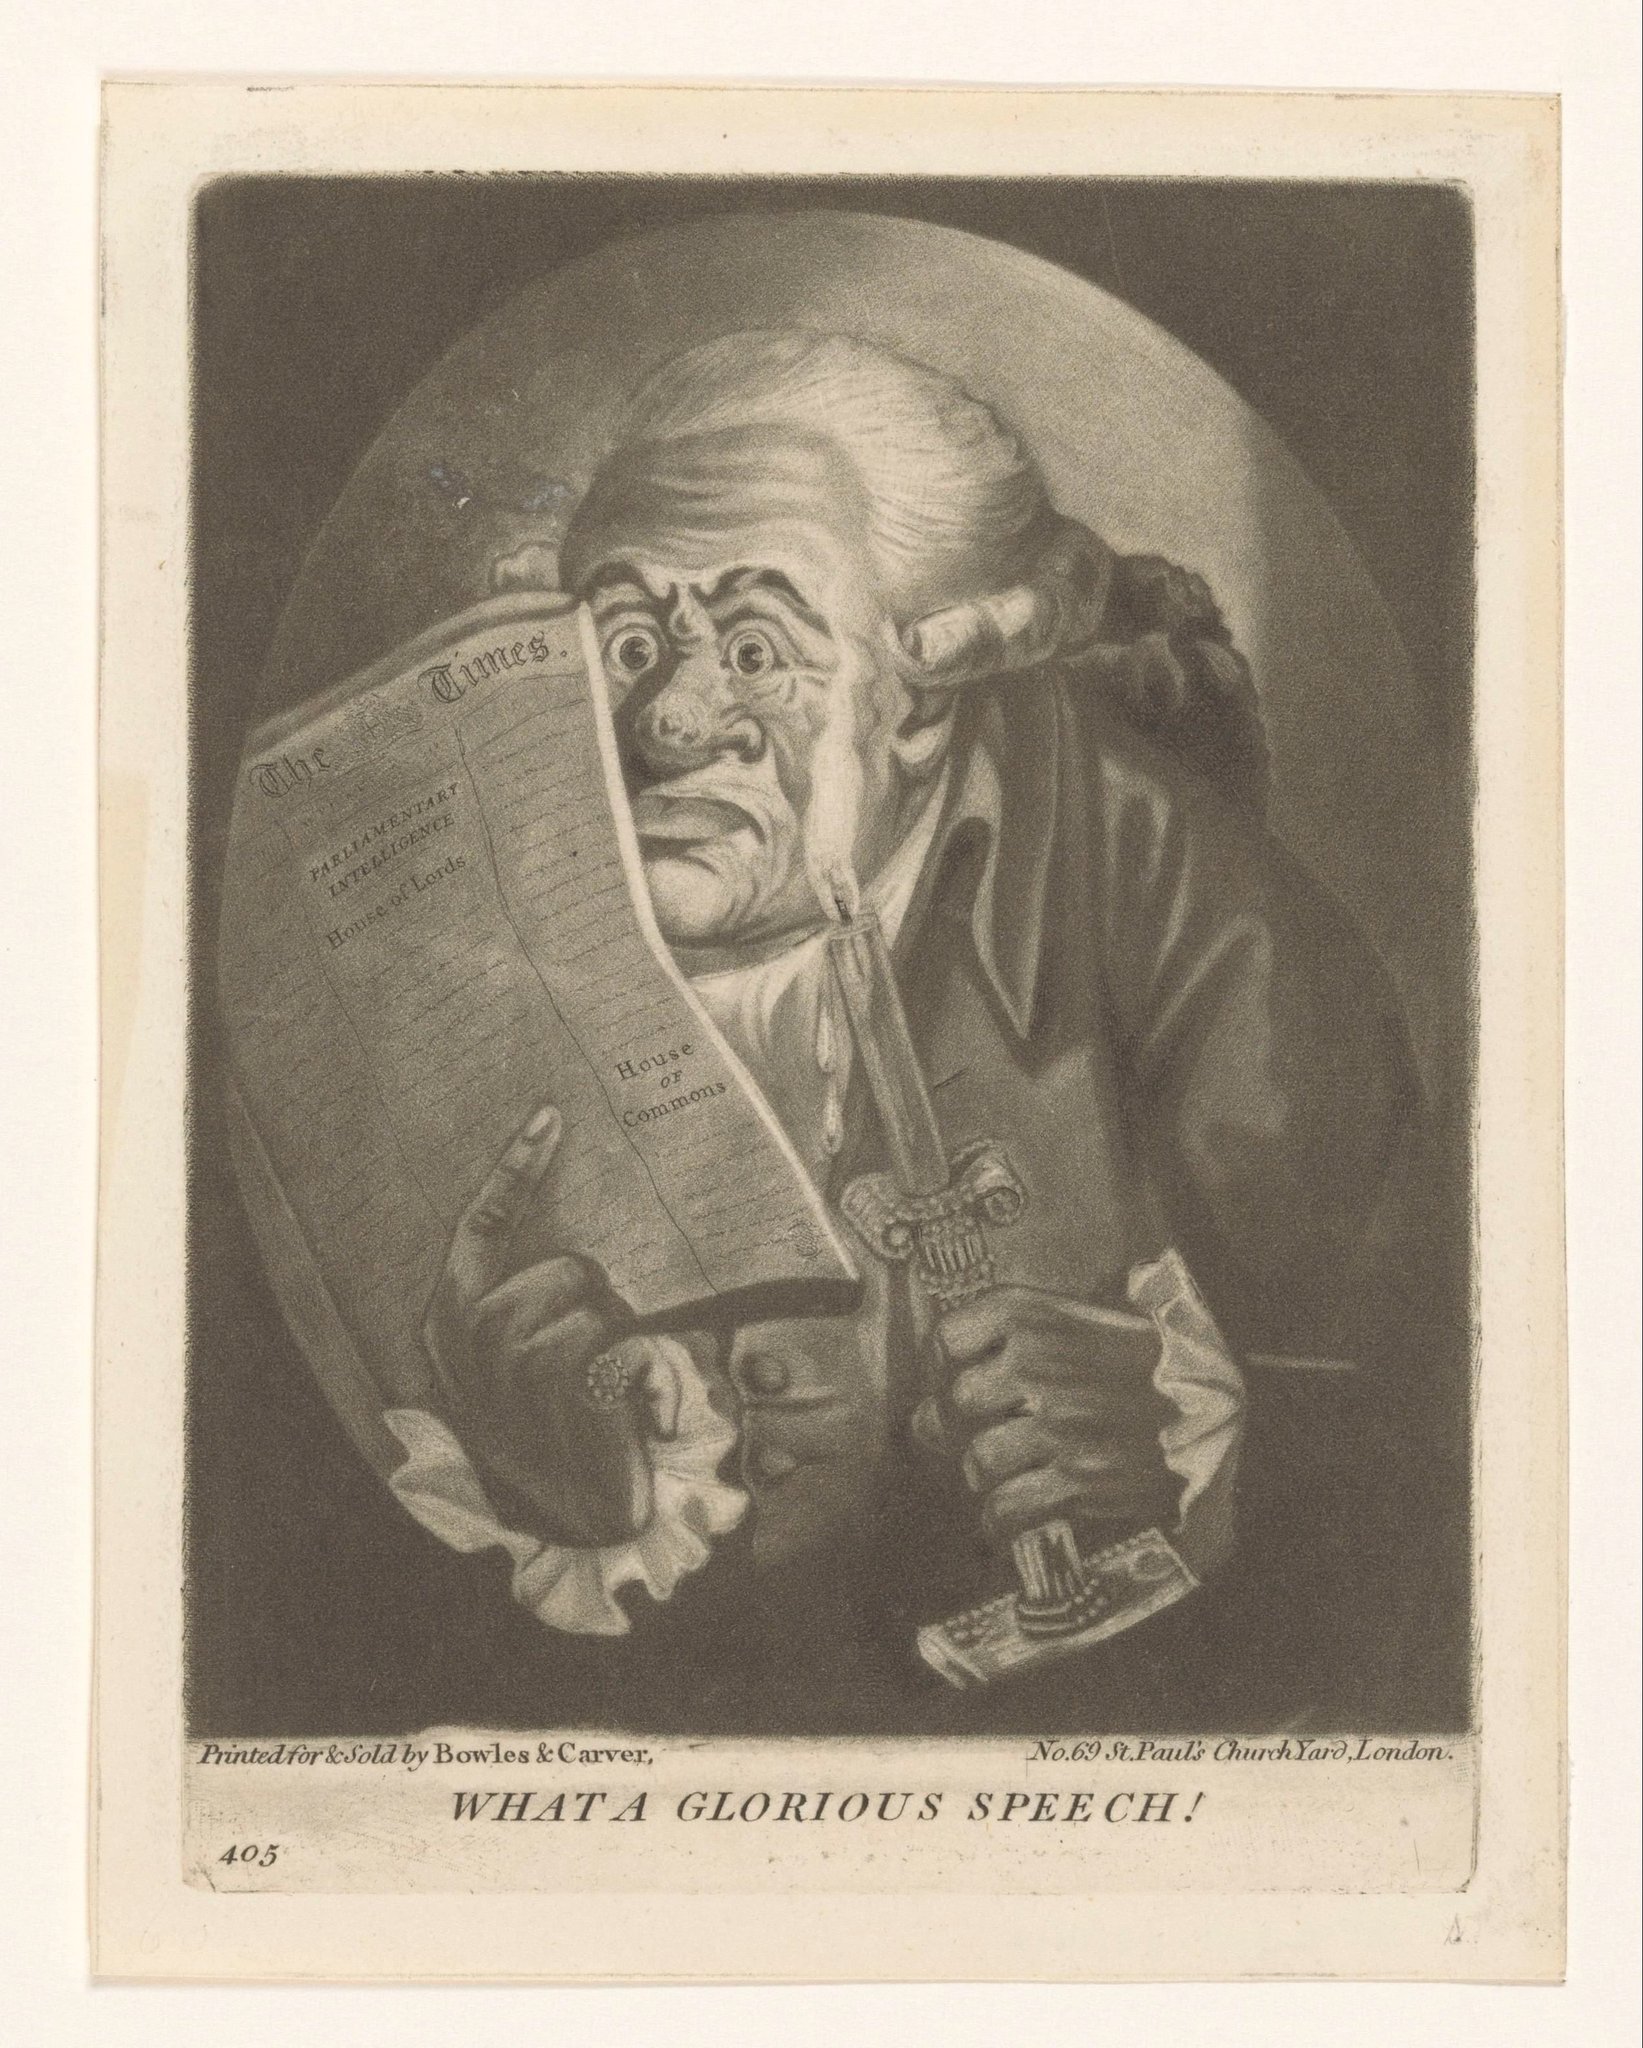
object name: print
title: What a glorious speech!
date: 1793-1832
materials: paper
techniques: etching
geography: london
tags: reading, candle, newspaper, news-sheet, political caricatures and satires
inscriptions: collector's mark: Lugt 2228, collector's mark: Lugt 4779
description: De prent maakt deel uit van een serie satirische prenten in ovalen, uitgegeven door Bowles & Carver. Mogelijk is de serie eerder uitgegeven door Carrington Bowles.